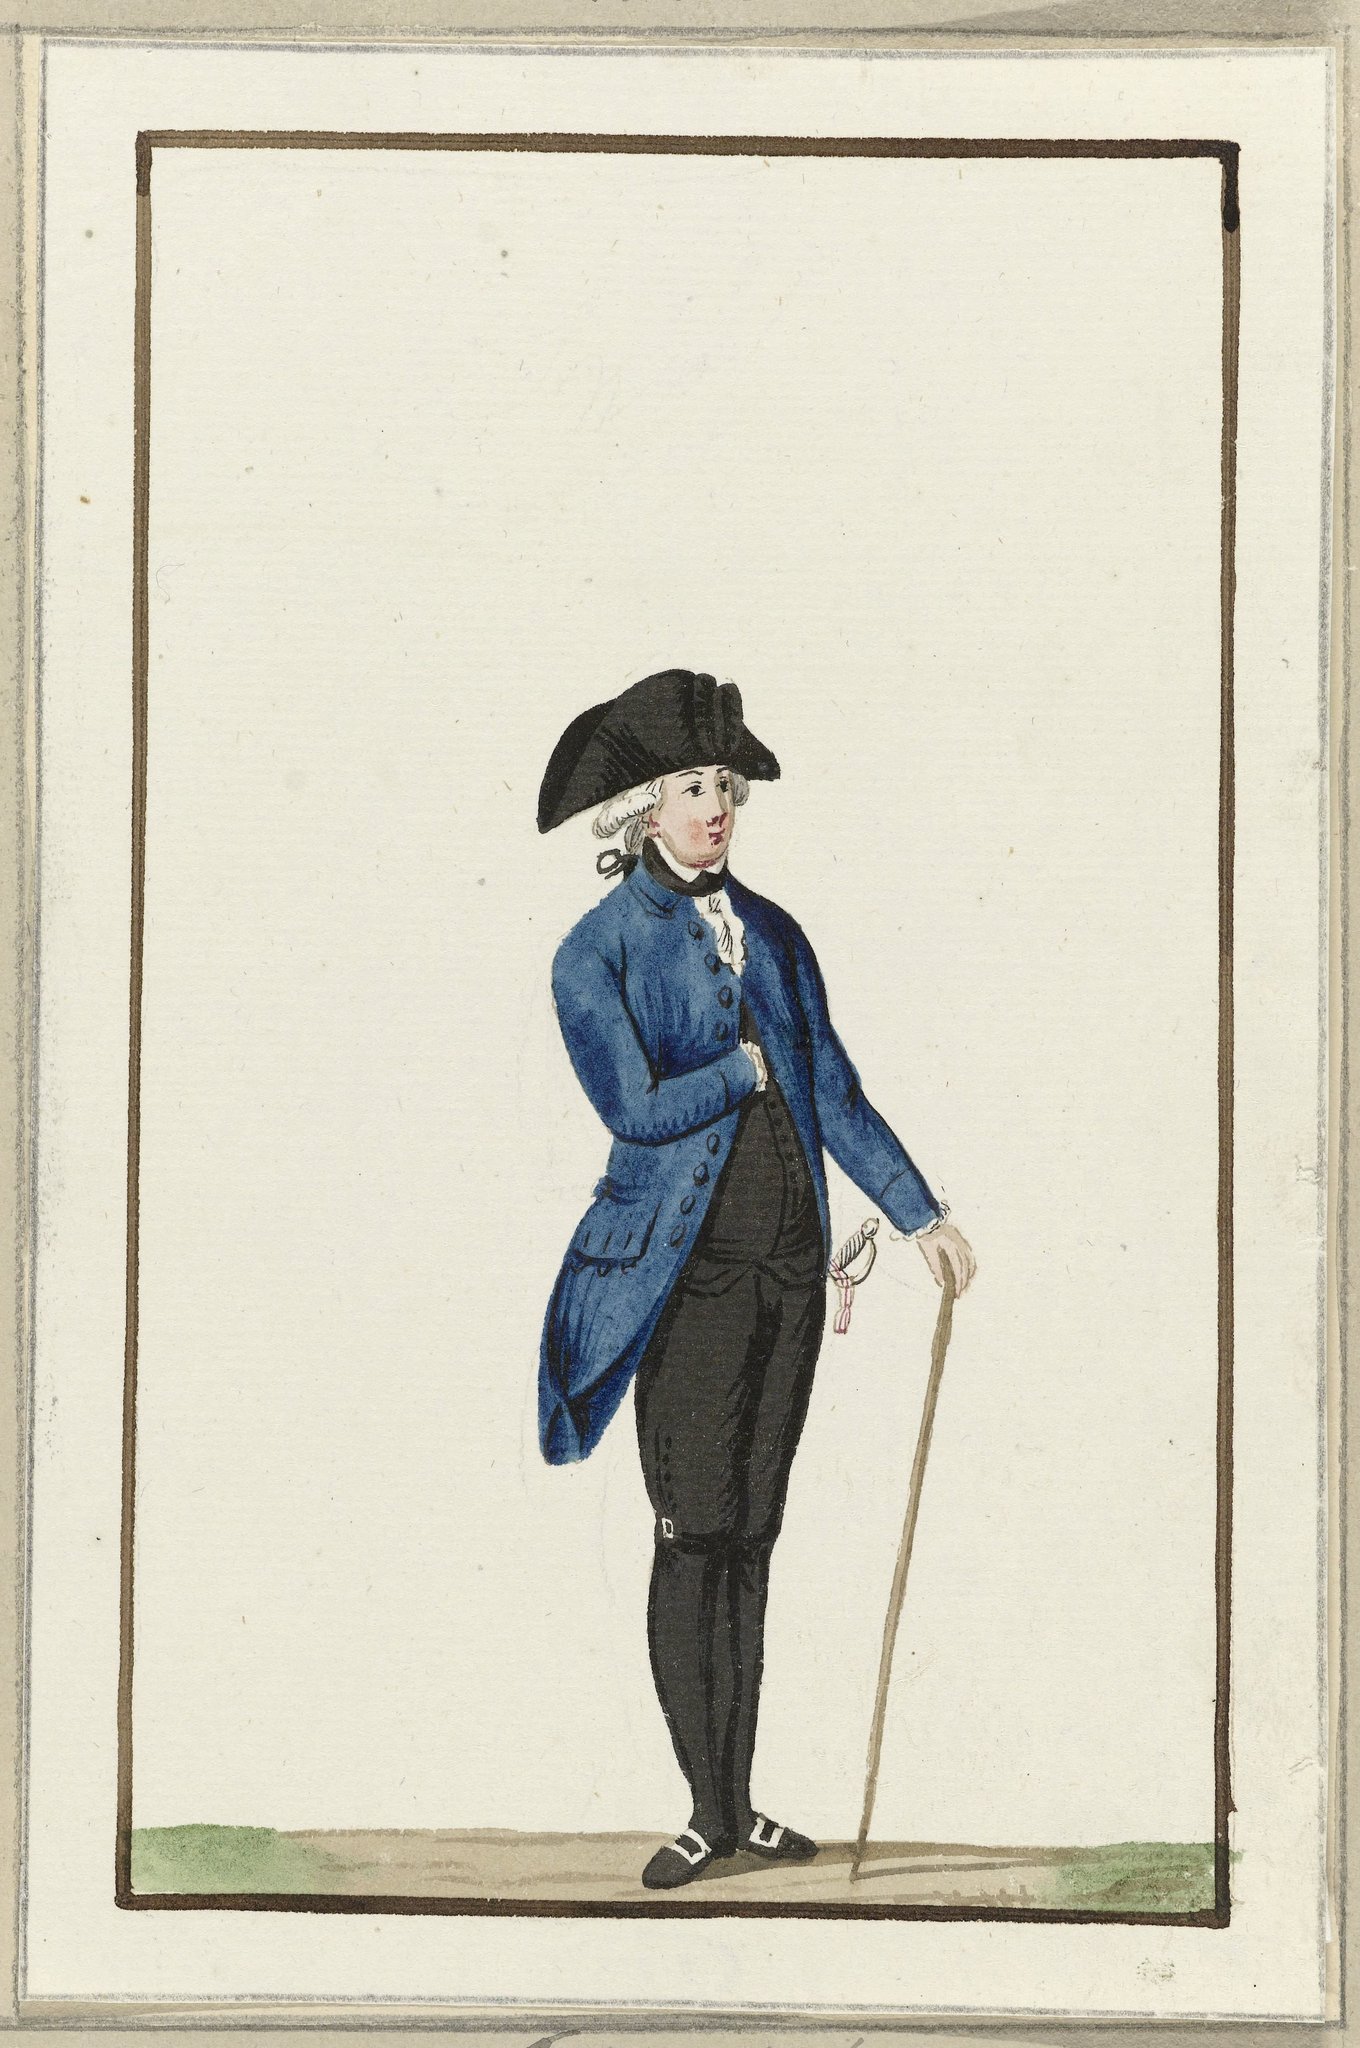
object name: drawing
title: Montering van het exercitiegenootschap van Zwolle, ca. 1787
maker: Anonymous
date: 1787-1790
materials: paper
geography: northern netherlands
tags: (military) uniforms (+ citizen soldiery, civil guard, citizen militia), patriots (1780-1795)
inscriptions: collector's mark: Lugt 2228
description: Uniform van het exercitiegenootschap van Zwolle. Onderdeel van een serie van 32 tekeningen van de verschillende monteringen (uniformen) van patriotse schutterijen en burgerkorpsen in Nederland in 1787.